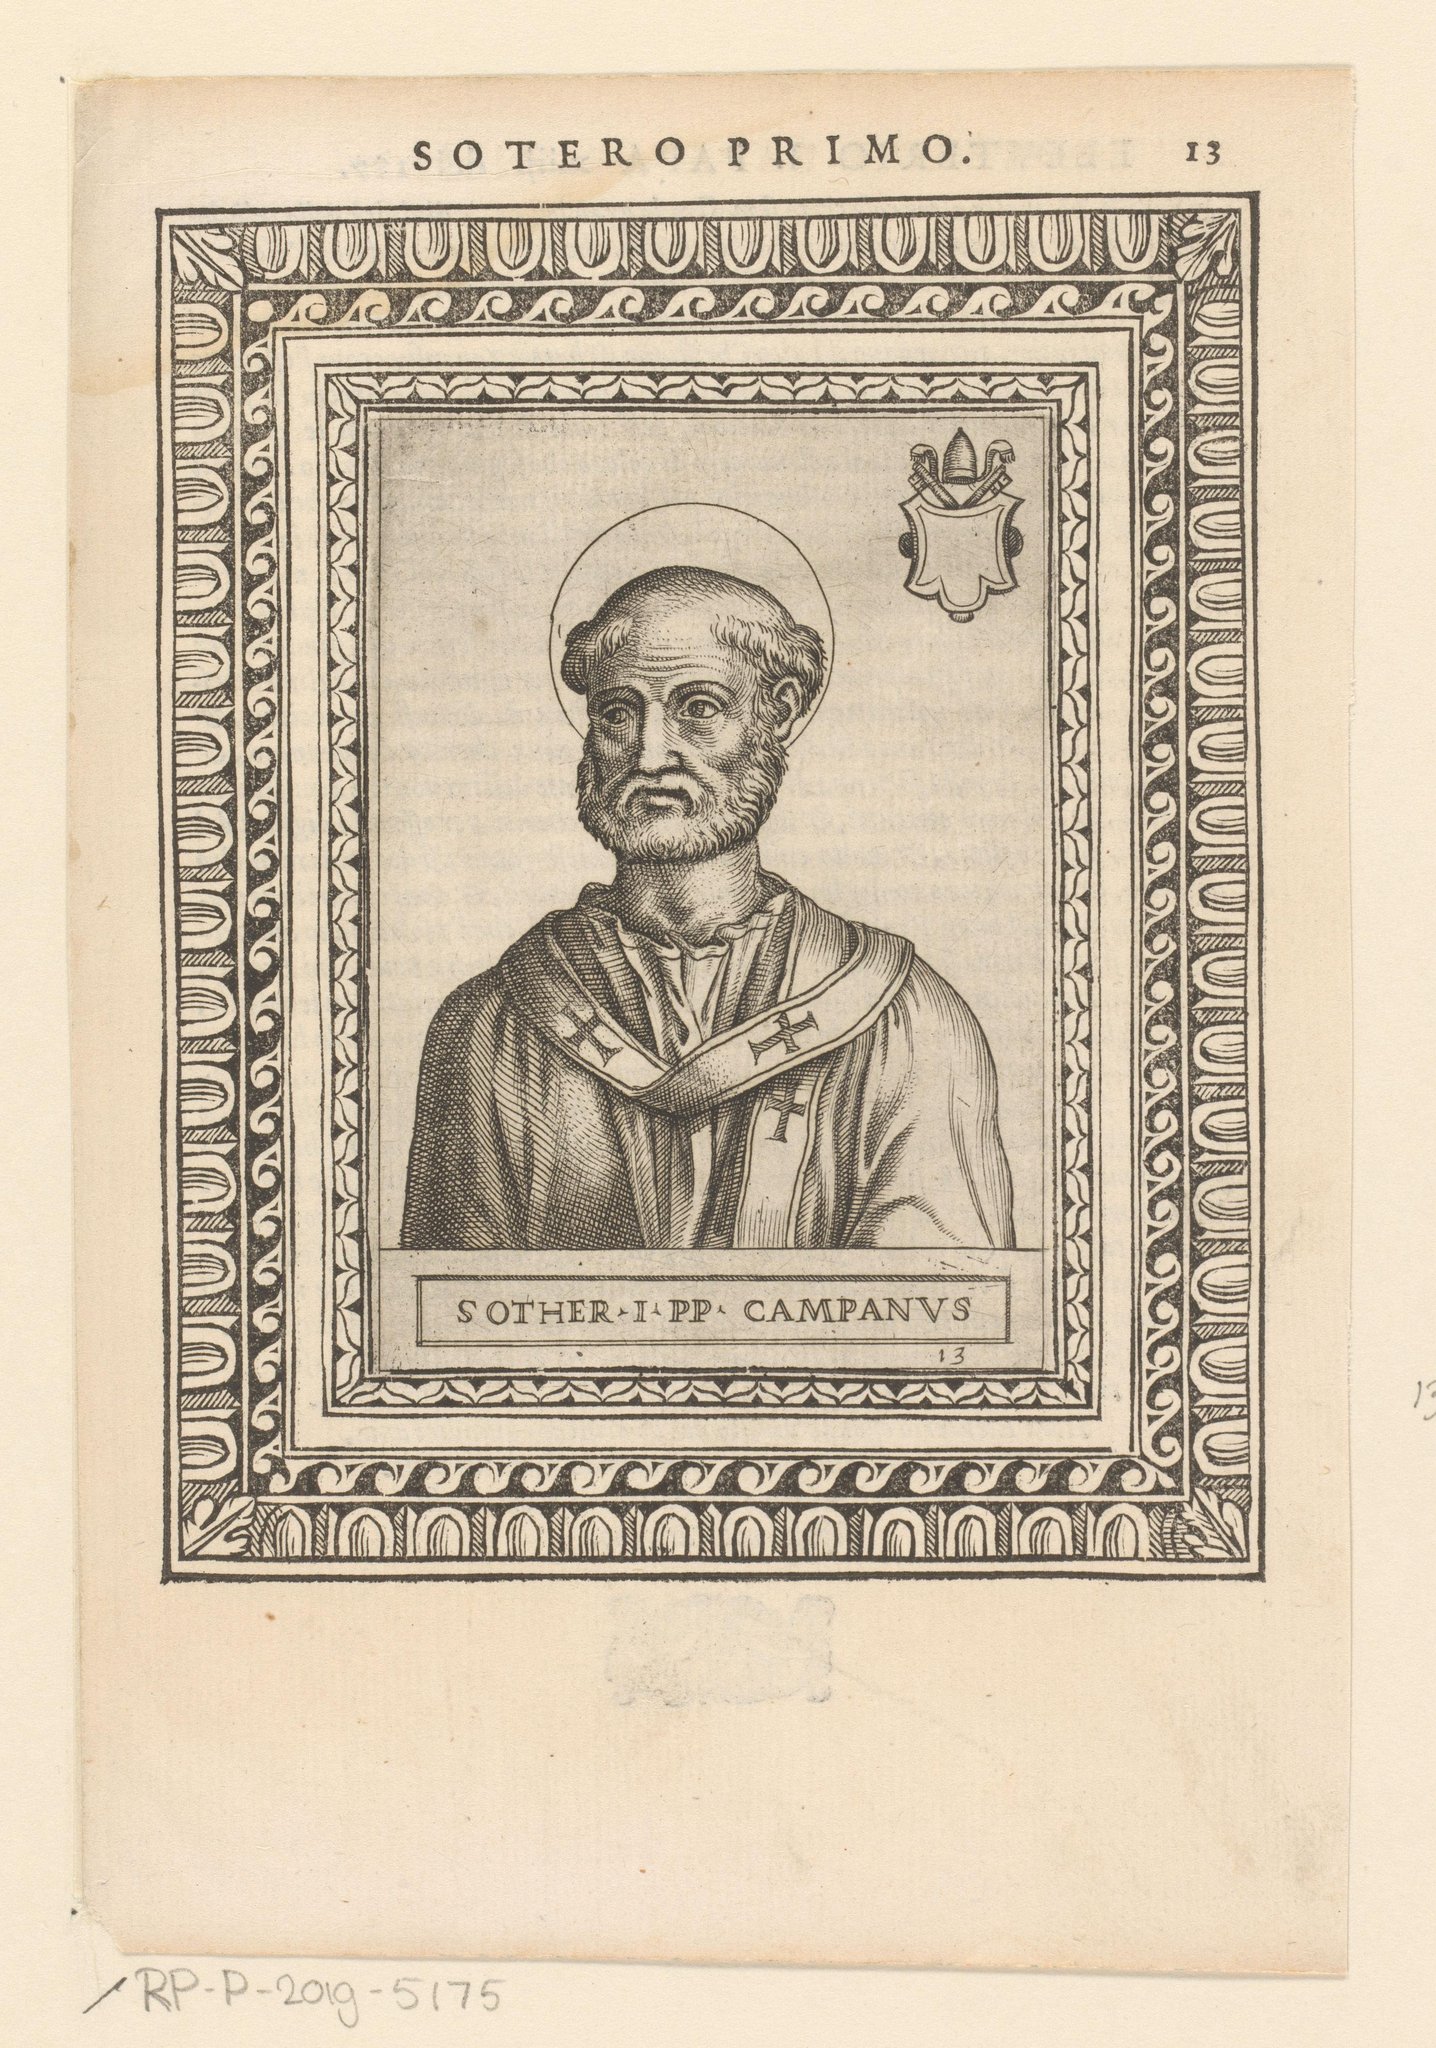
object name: book illustration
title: Portret van paus Soter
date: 1587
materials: paper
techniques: engraving, letterpress printing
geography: rome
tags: historical persons, pope, armorial bearing, heraldry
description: Prent uit: Ciccarelli, Antonio. Le vite de Pontefici di Antonio Ciccarelli (...). Rome: Domenico Basa, 1587. Prent voor het eerst verschenen in: Cavalieri, Giovanni Battista de'. Pontificum romanorum effigies (...). Rome: Domenico Basa en Francesco Zanetti, 1580. Prent ook gebruikt in latere publicaties.